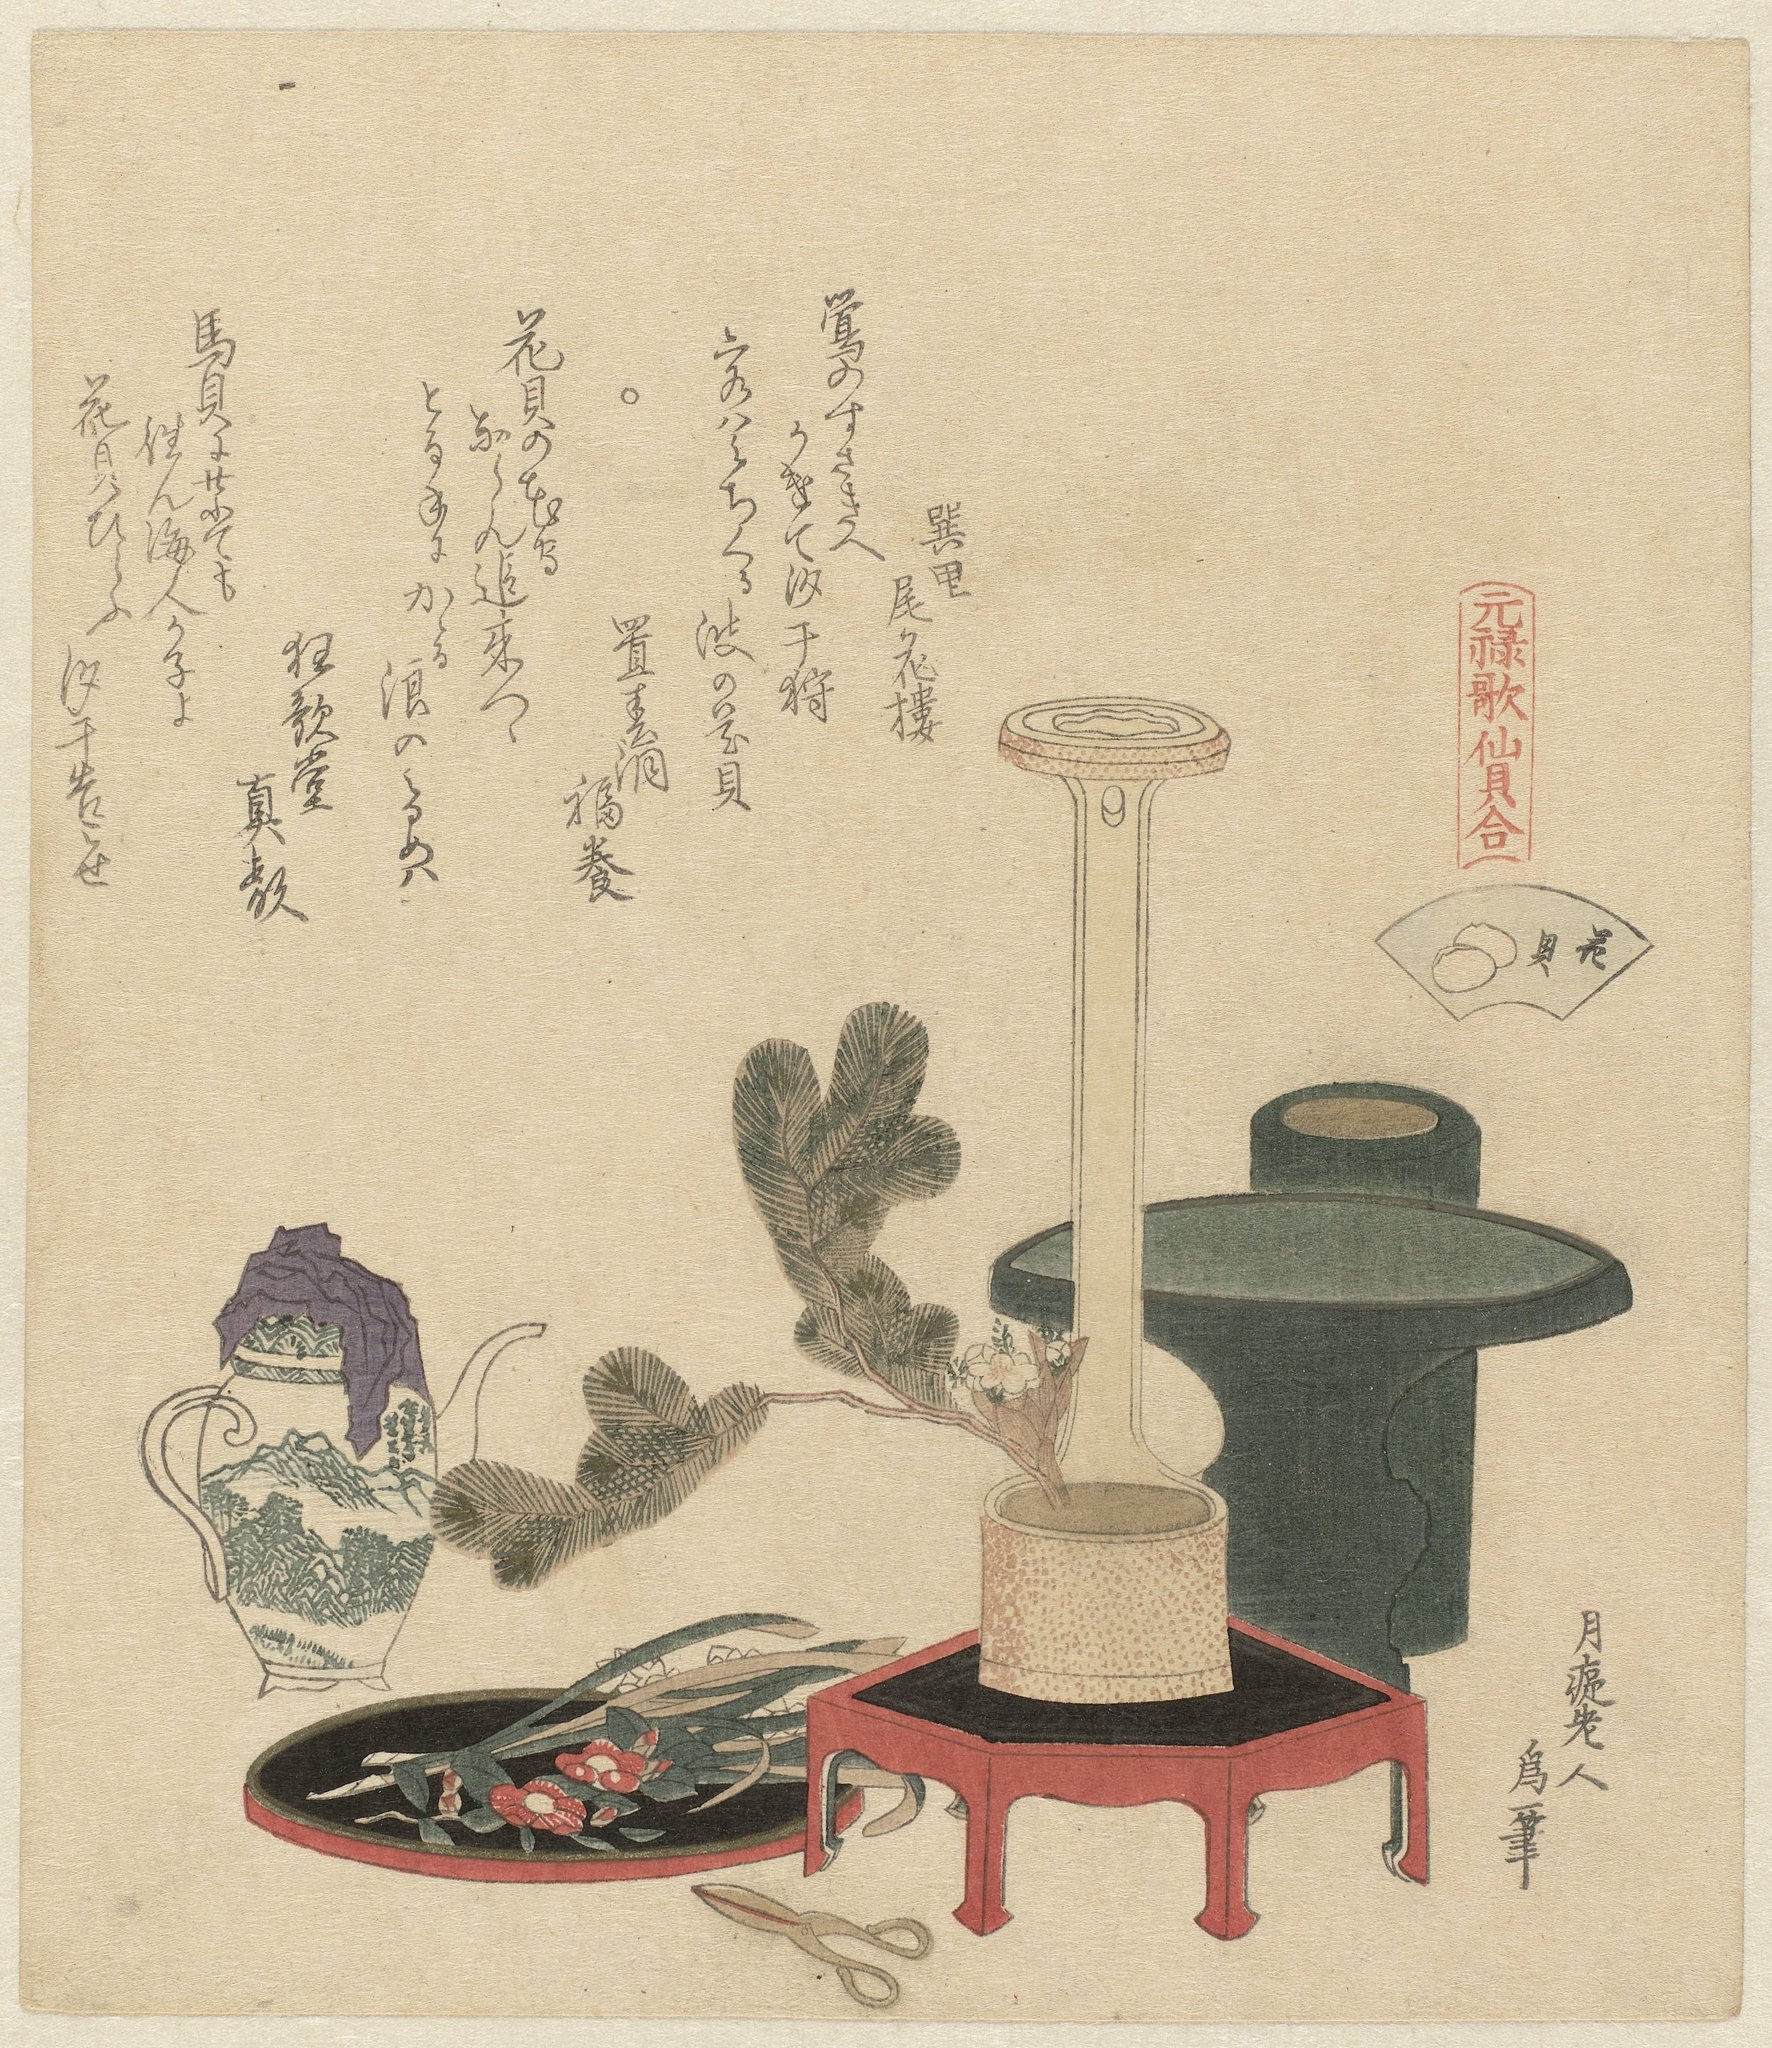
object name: surimono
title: A Flower Arrangement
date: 1868-1912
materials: paper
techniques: woodcut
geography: japan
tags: arranging flowers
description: Een surimono is een luxe uitgevoerde prent waarop beeld met één of meerdere gedichten gecombineerd is. Bij het drukken van een surimono werd vaak gebruik gemaakt van dikker papier, blinddruk en metaal pigmenten, zoals koper- en zilverpoeder. De prenten werden vaak in opdracht van dichters gemaakt en als exclusief geschenk aan vrienden en relaties gegeven.